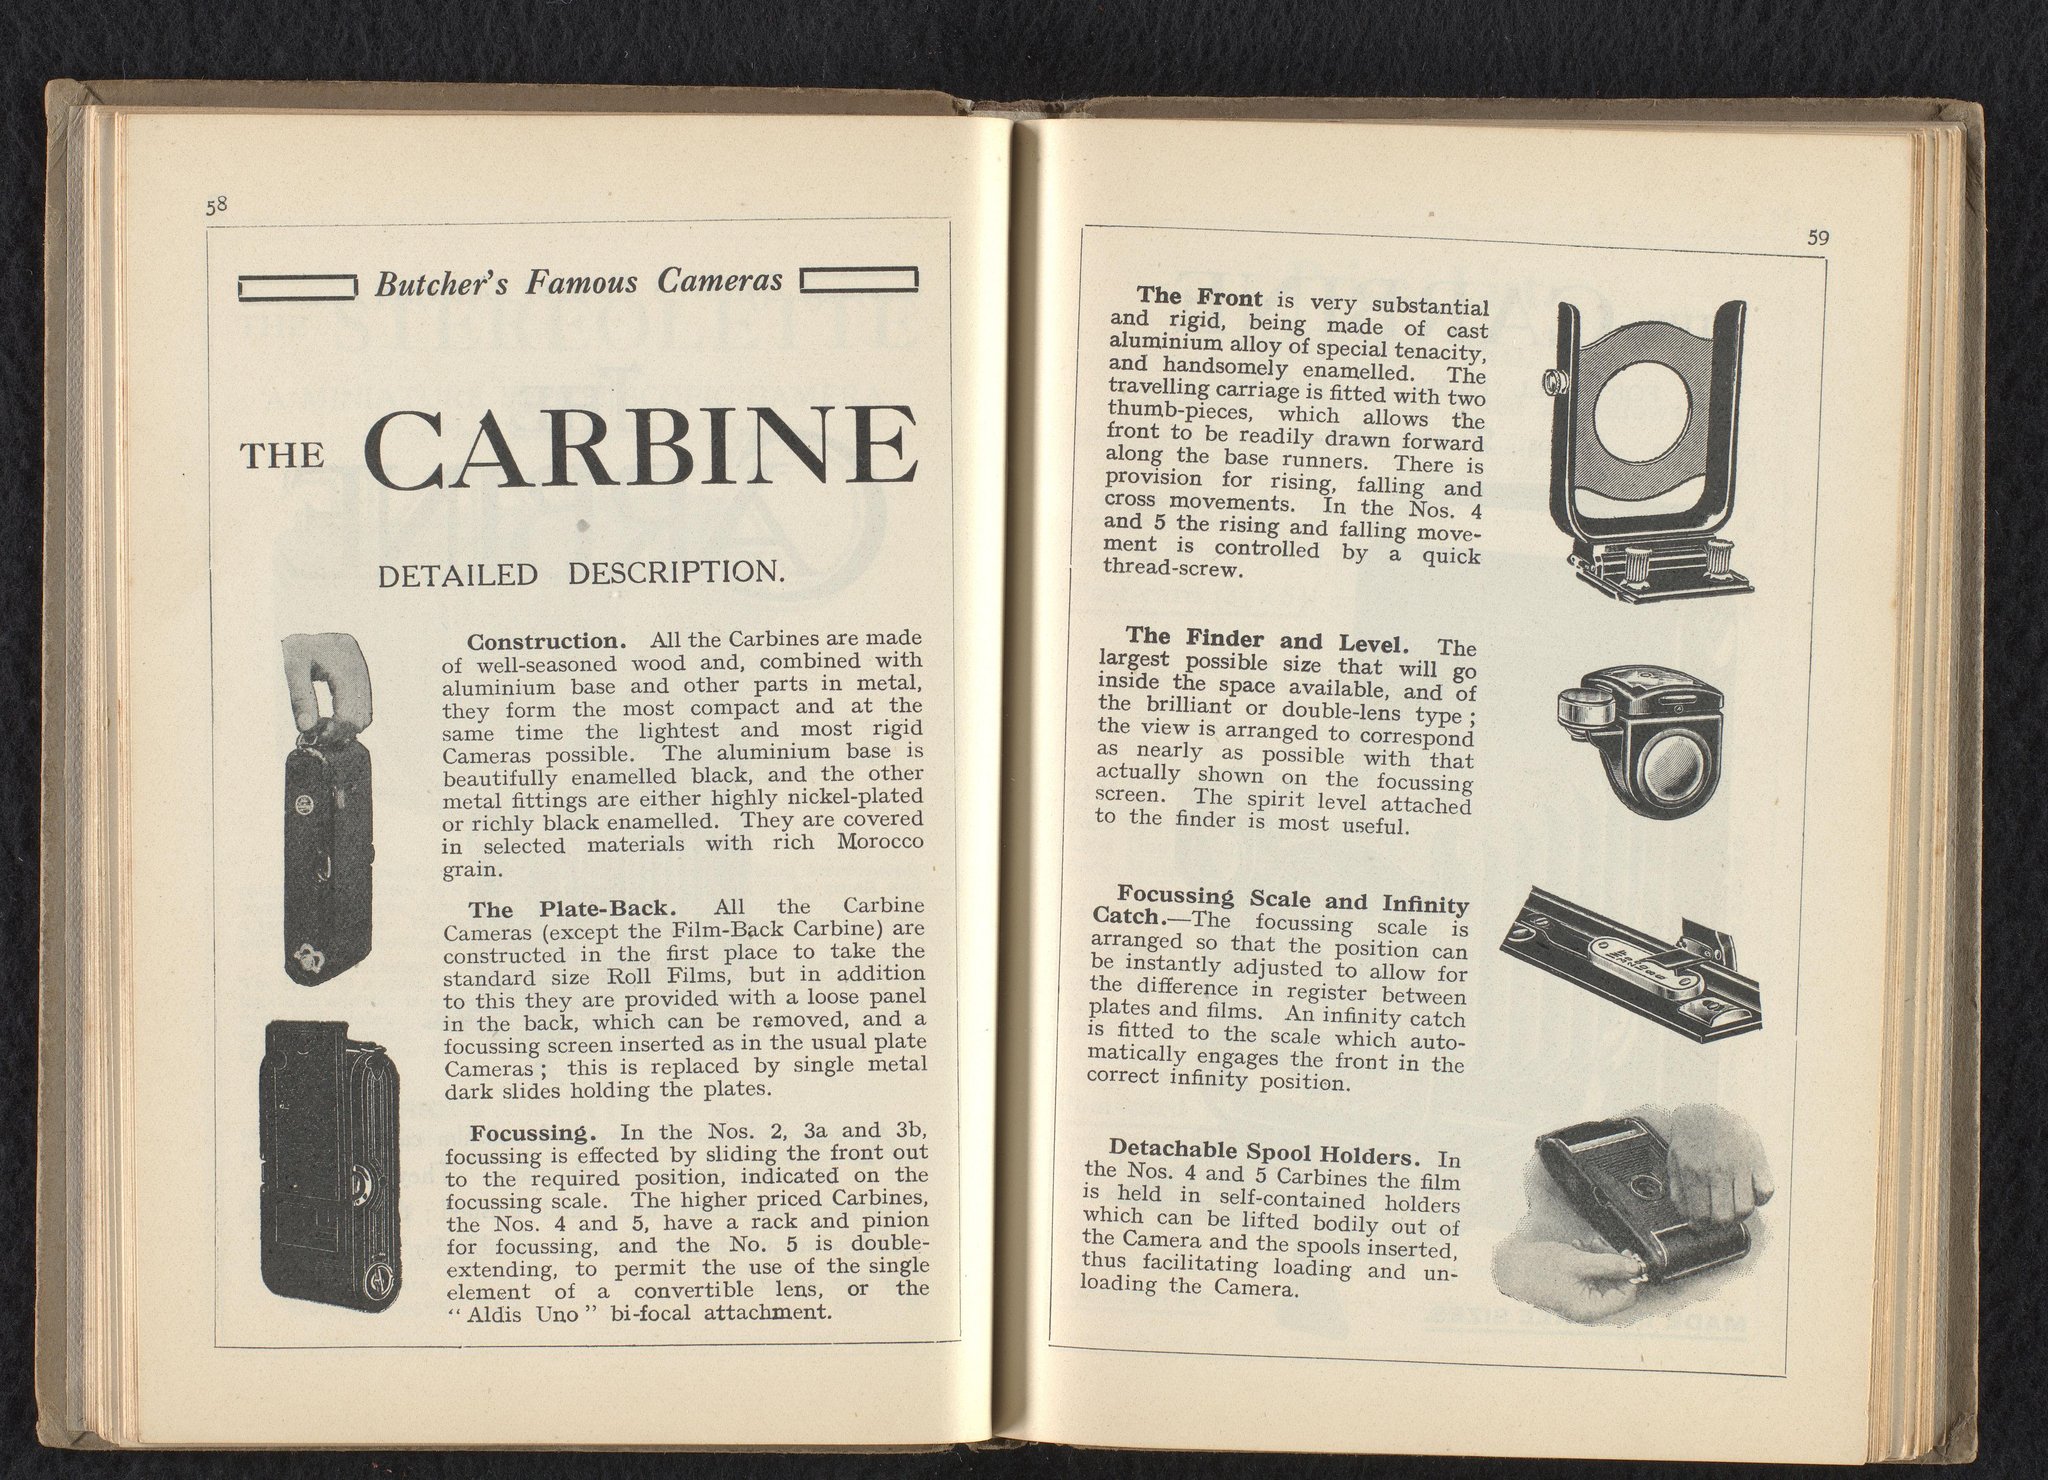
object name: page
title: Afneembare spoelhouders van de Carbine camera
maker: Anonymous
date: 1907-1912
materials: paper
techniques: letterpress printing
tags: camera ~ photography